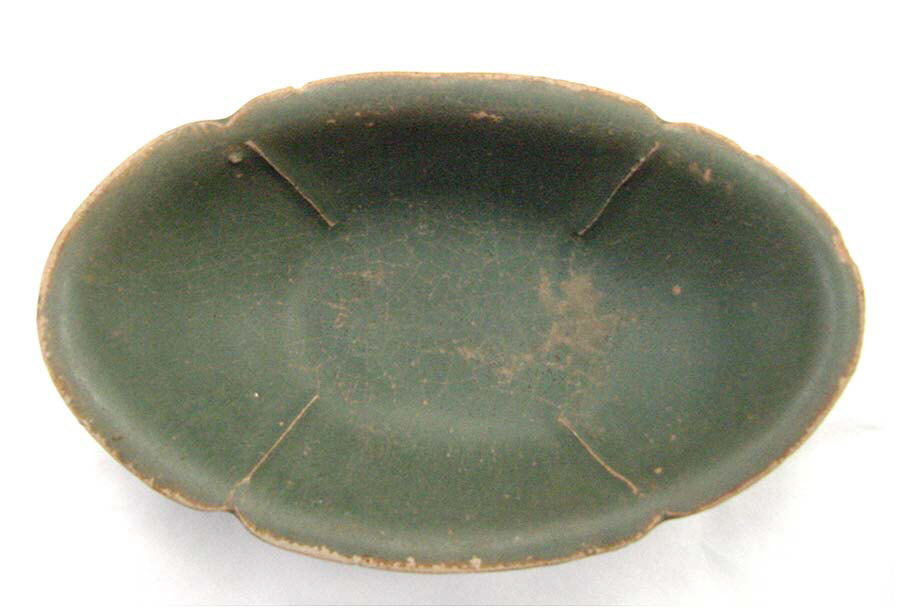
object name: bowl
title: Oval bowl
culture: chinese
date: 701-900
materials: glaze, stoneware